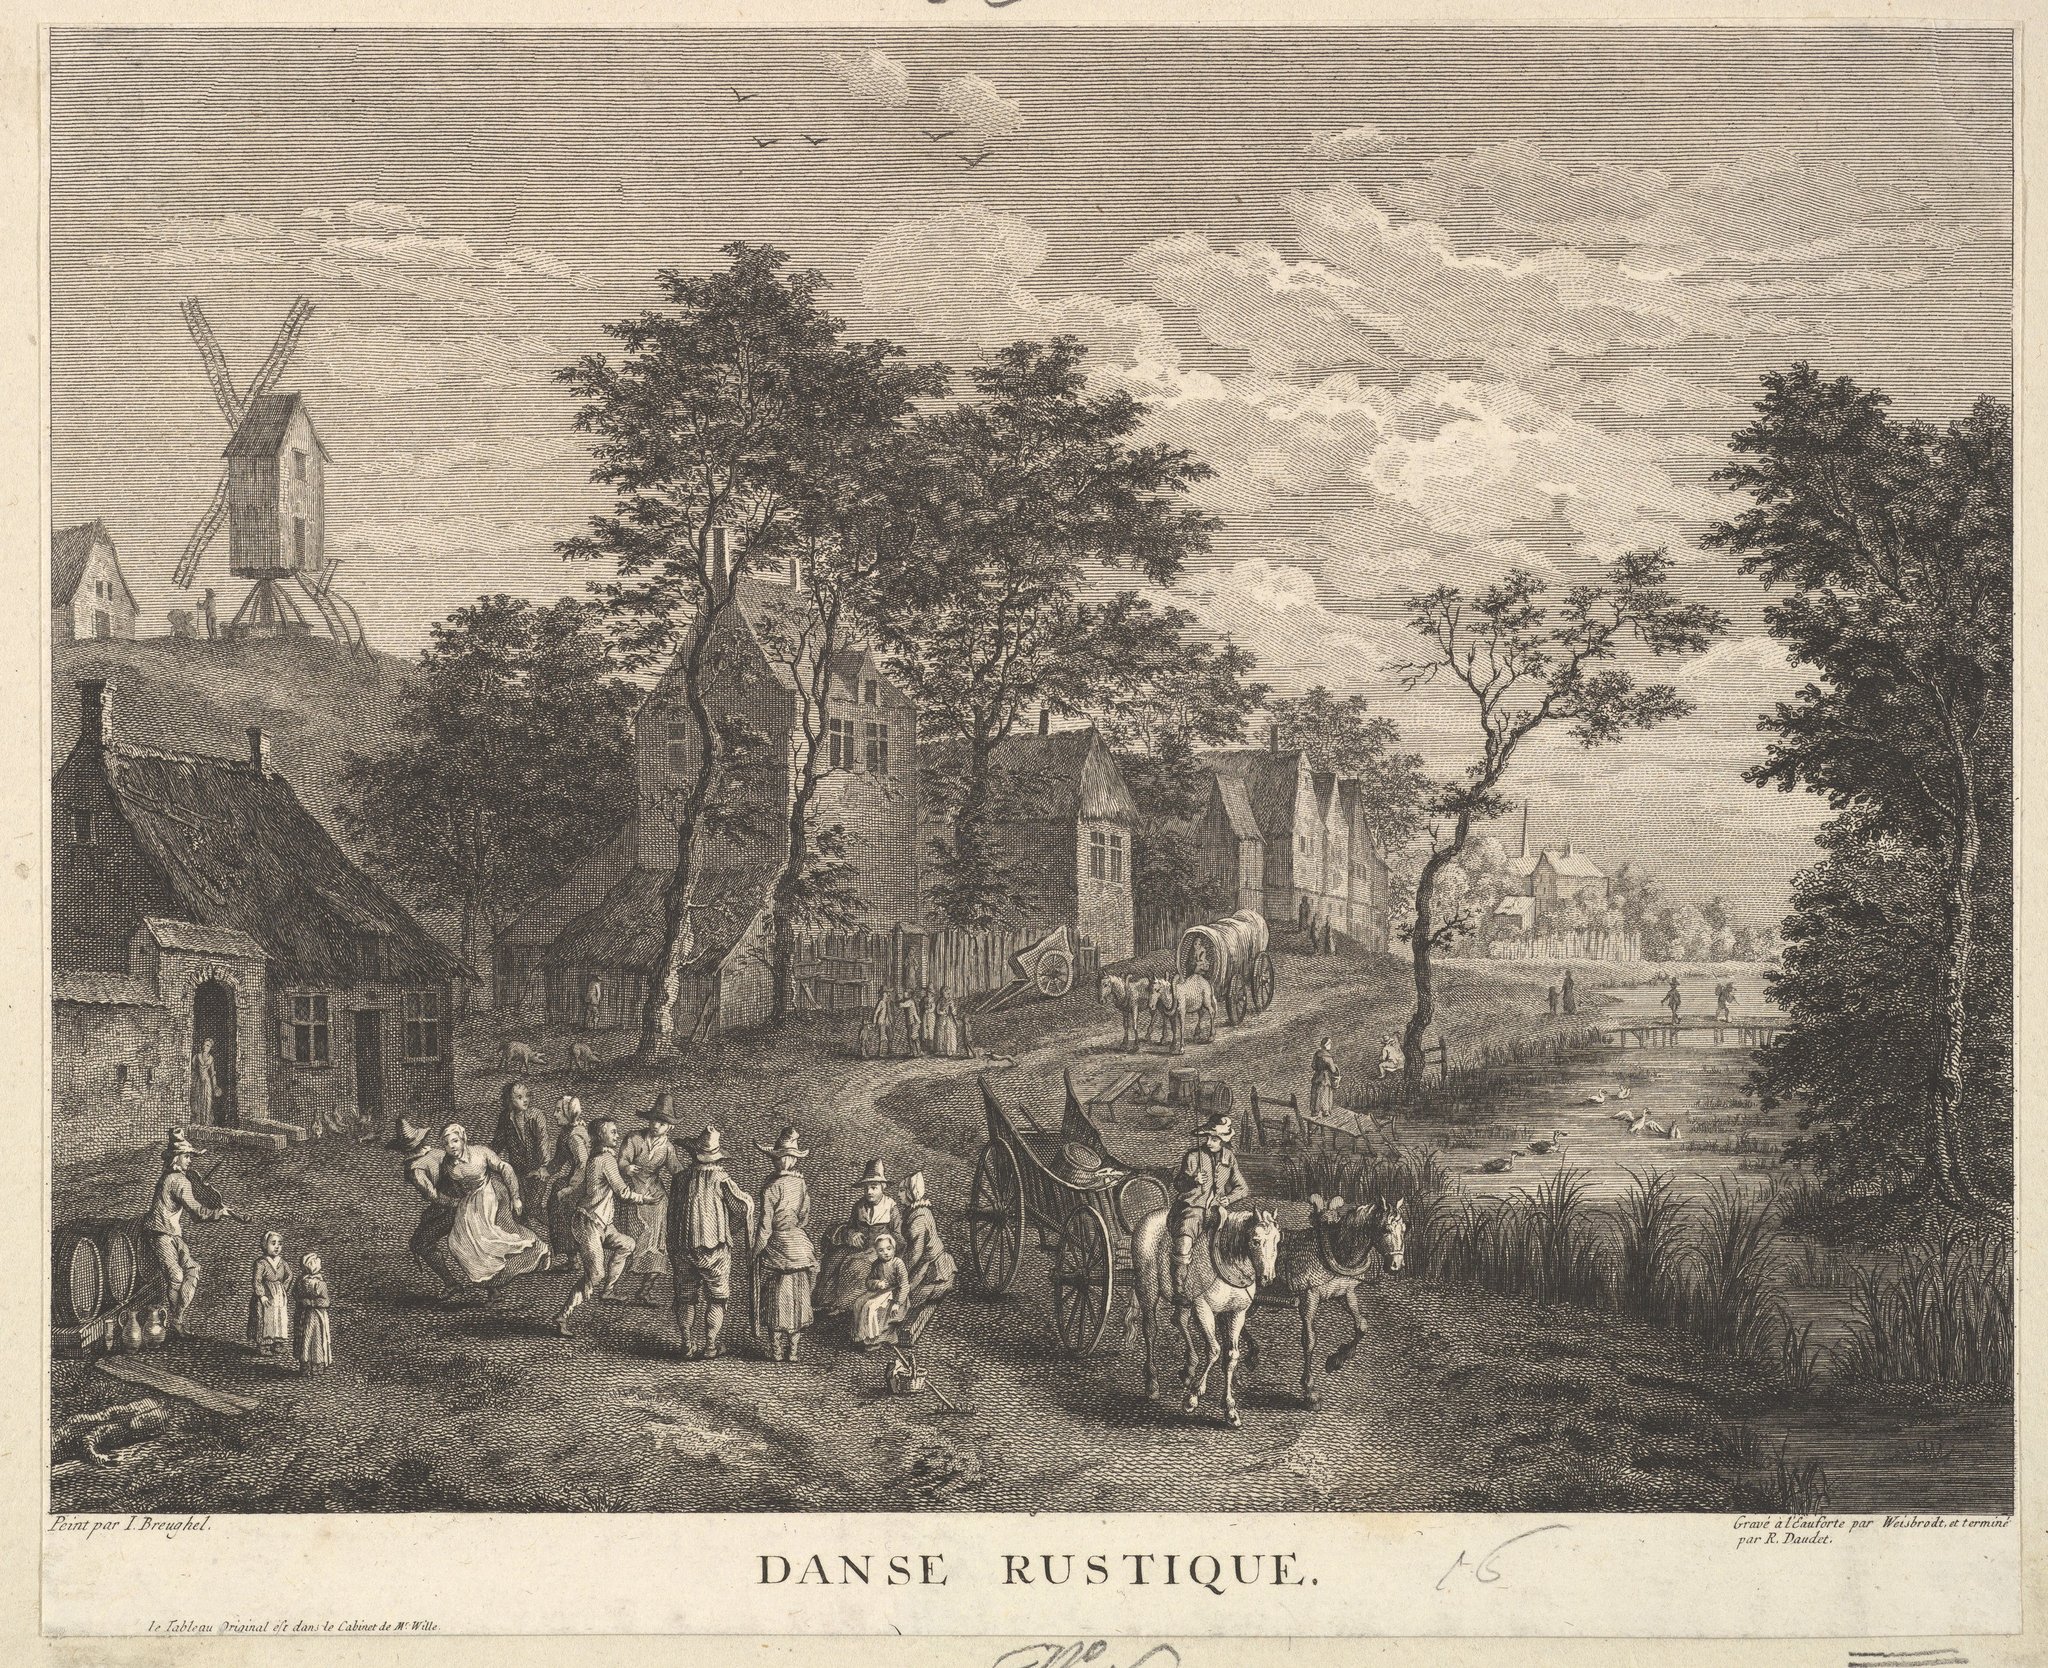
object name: print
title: Rustic Dance (Danse Rustique)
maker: robert daudet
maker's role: artist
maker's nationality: french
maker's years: 1737-1824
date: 1737-1824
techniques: engraving, etching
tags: dance,windmills,children,men,women,carriages